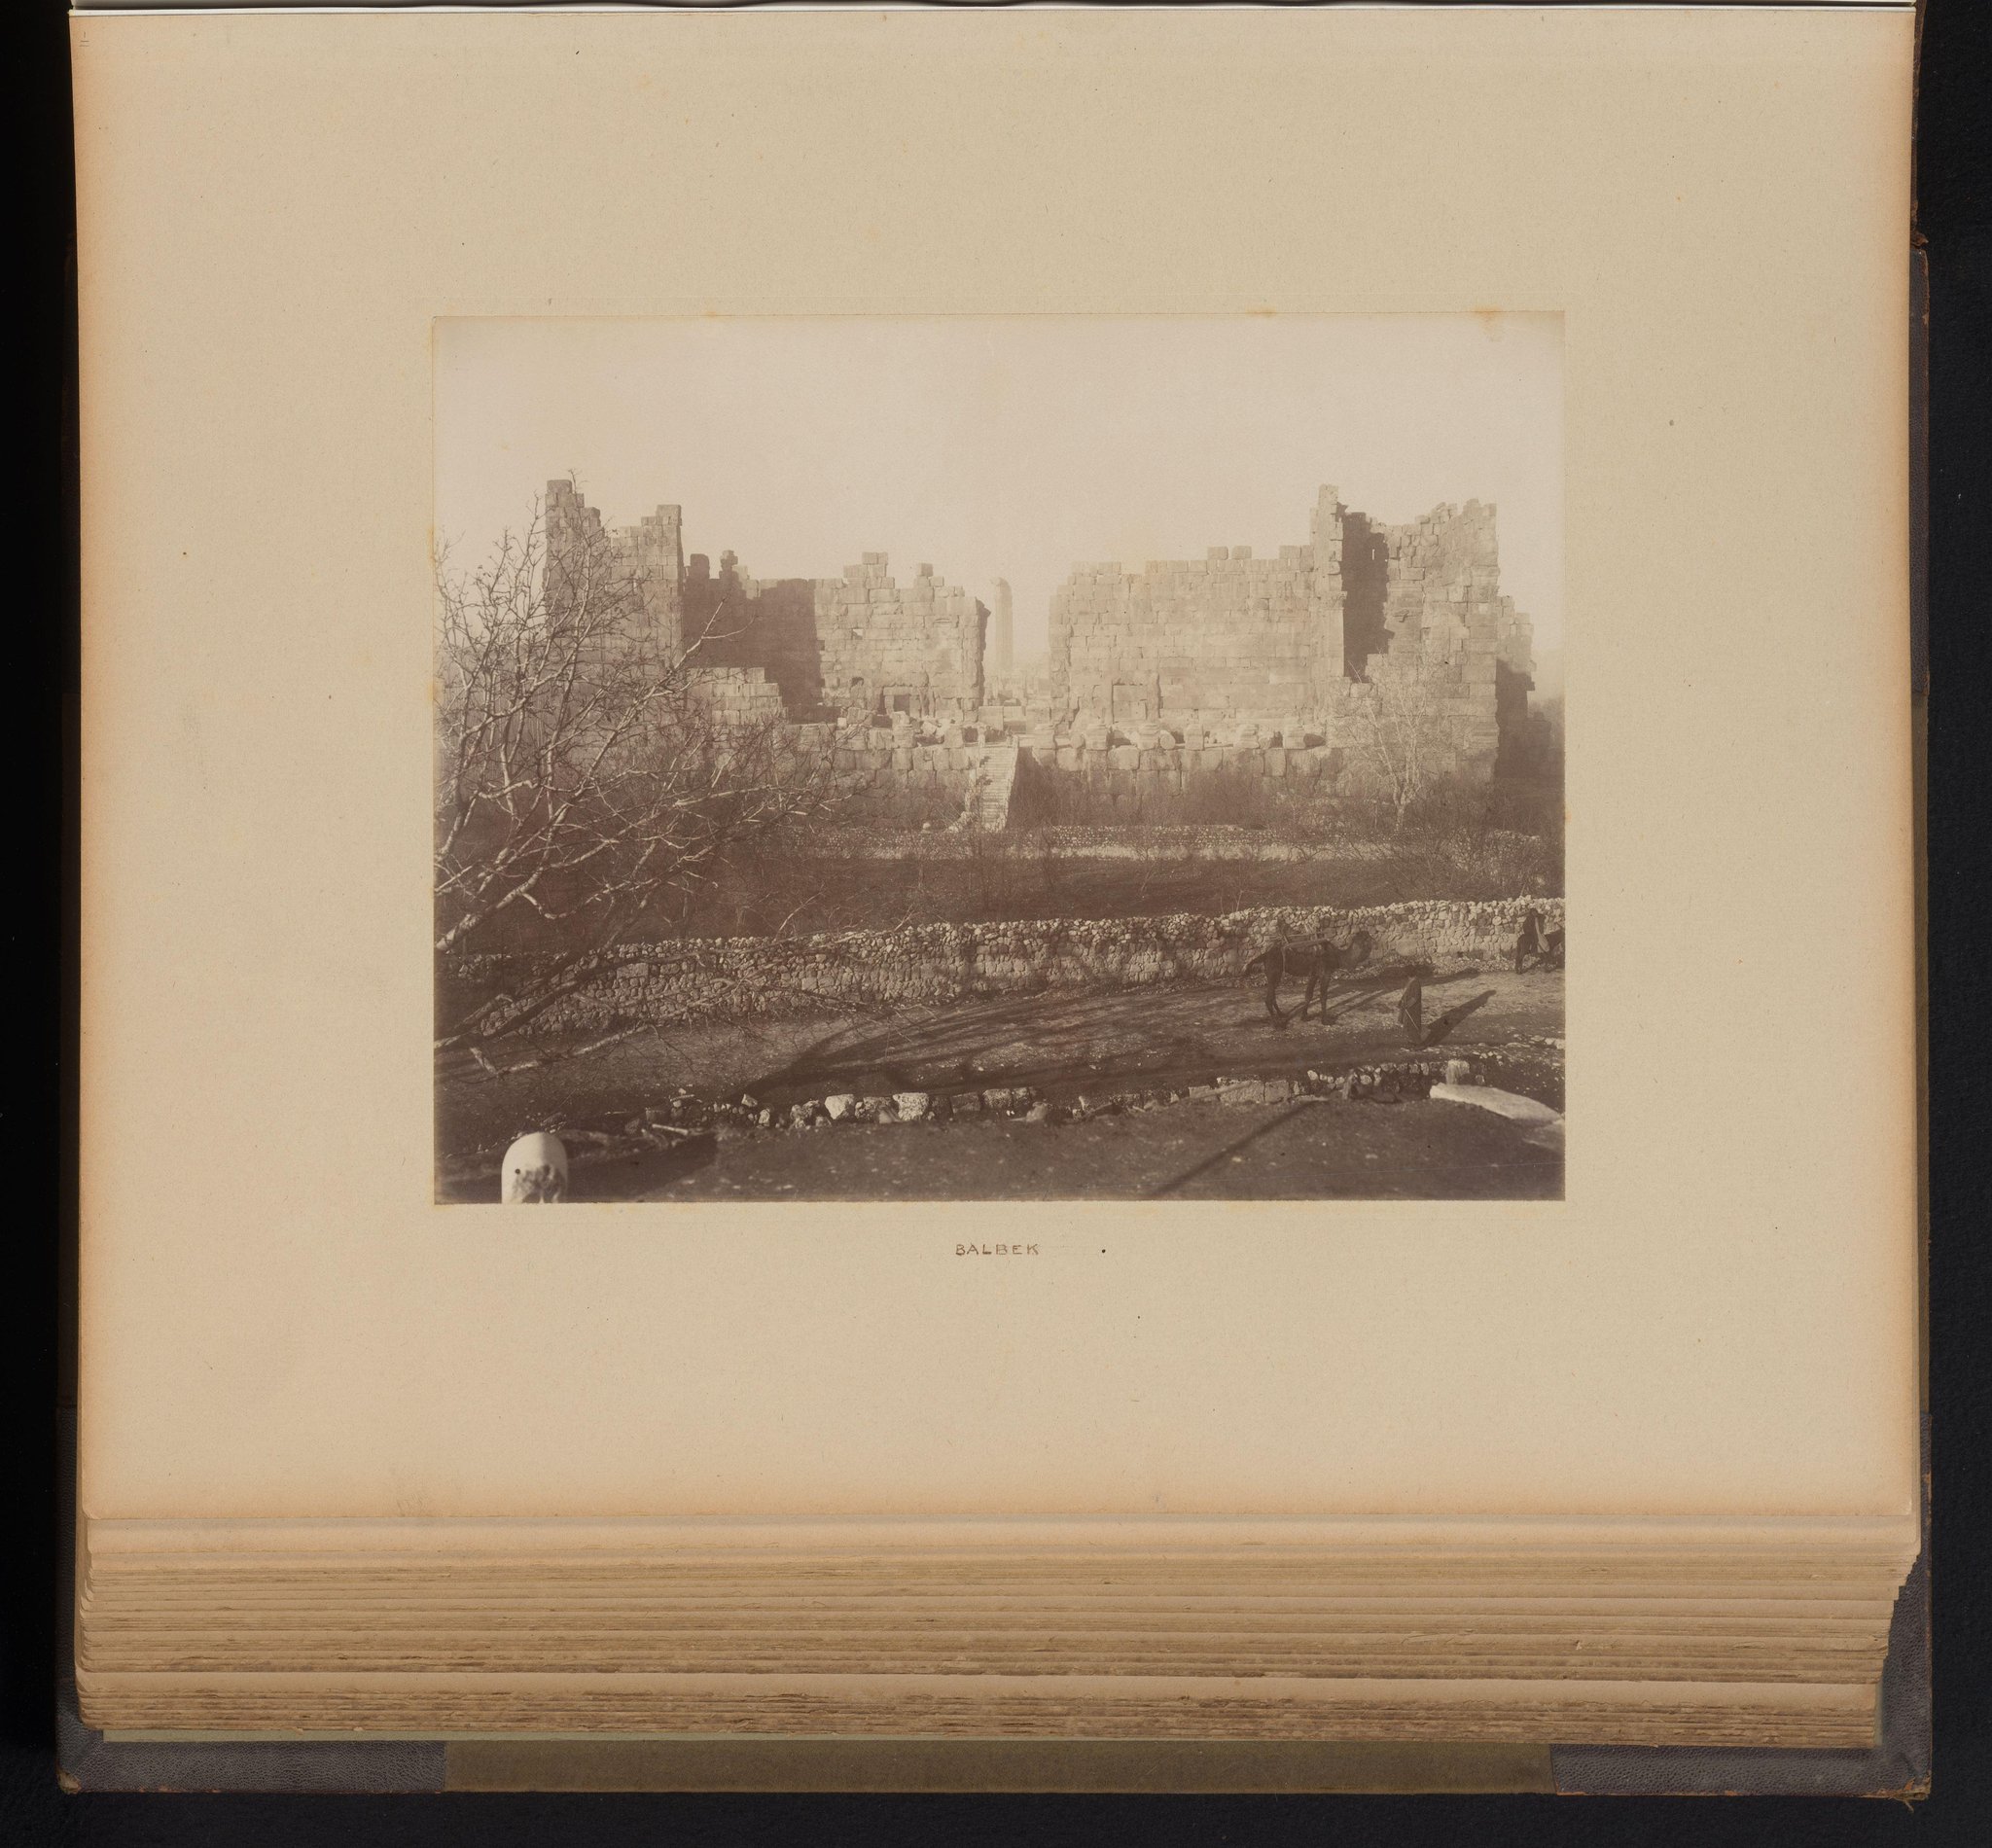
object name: album leaf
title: Balbek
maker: Anonymous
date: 1851-1910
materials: paper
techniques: albumen print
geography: baalbek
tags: landscape with ruins